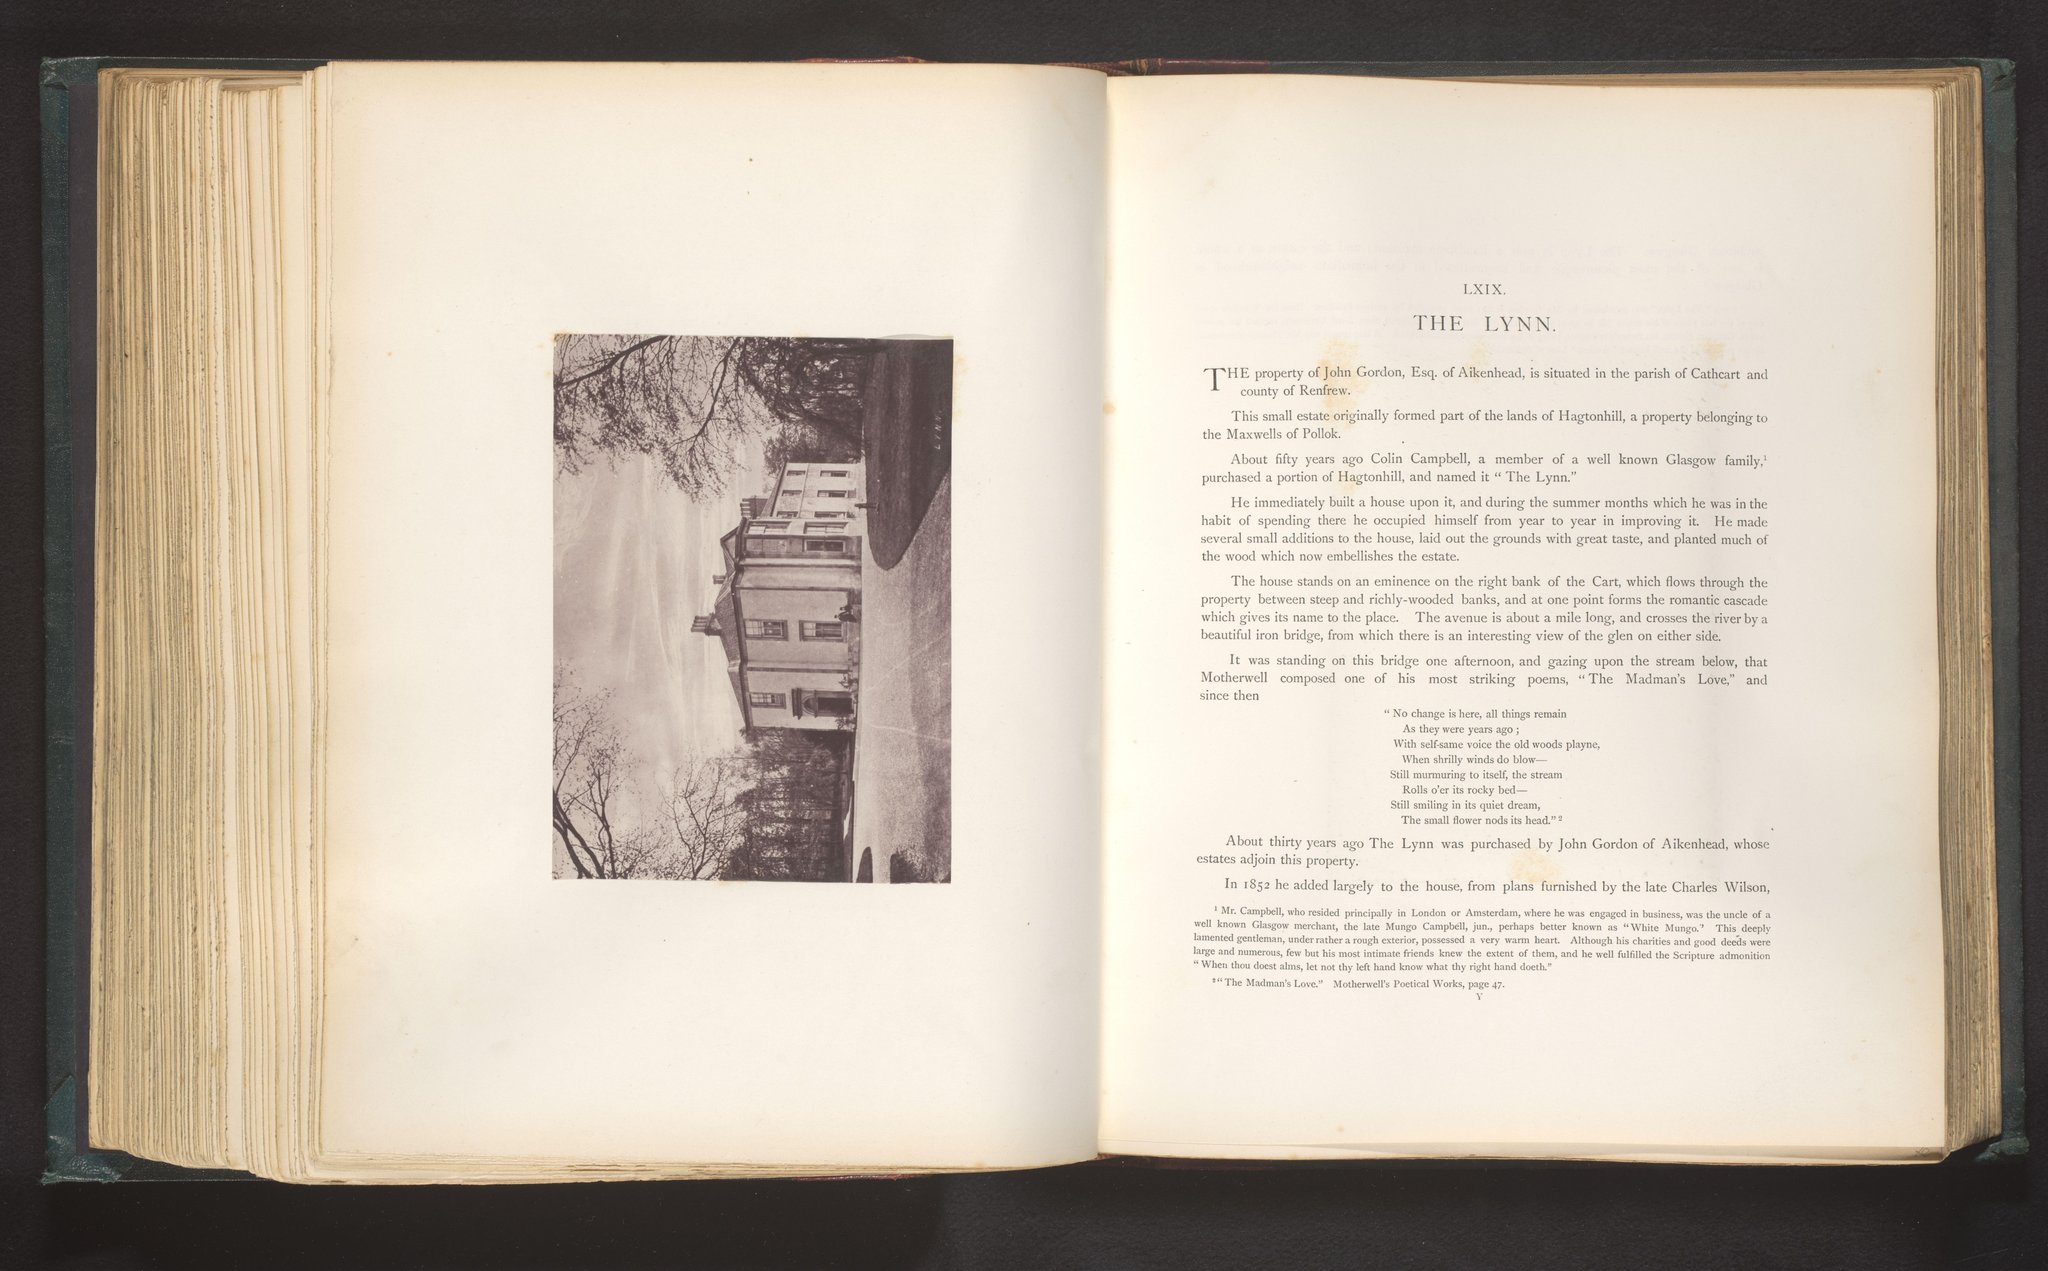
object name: photograph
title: The Lynn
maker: thomas annan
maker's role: fotograaf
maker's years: 1829-1887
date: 1868-1878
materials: paper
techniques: carbon print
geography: glasgow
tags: rural housing, e.g. country-house, villa, cottage, façade (of house or building)